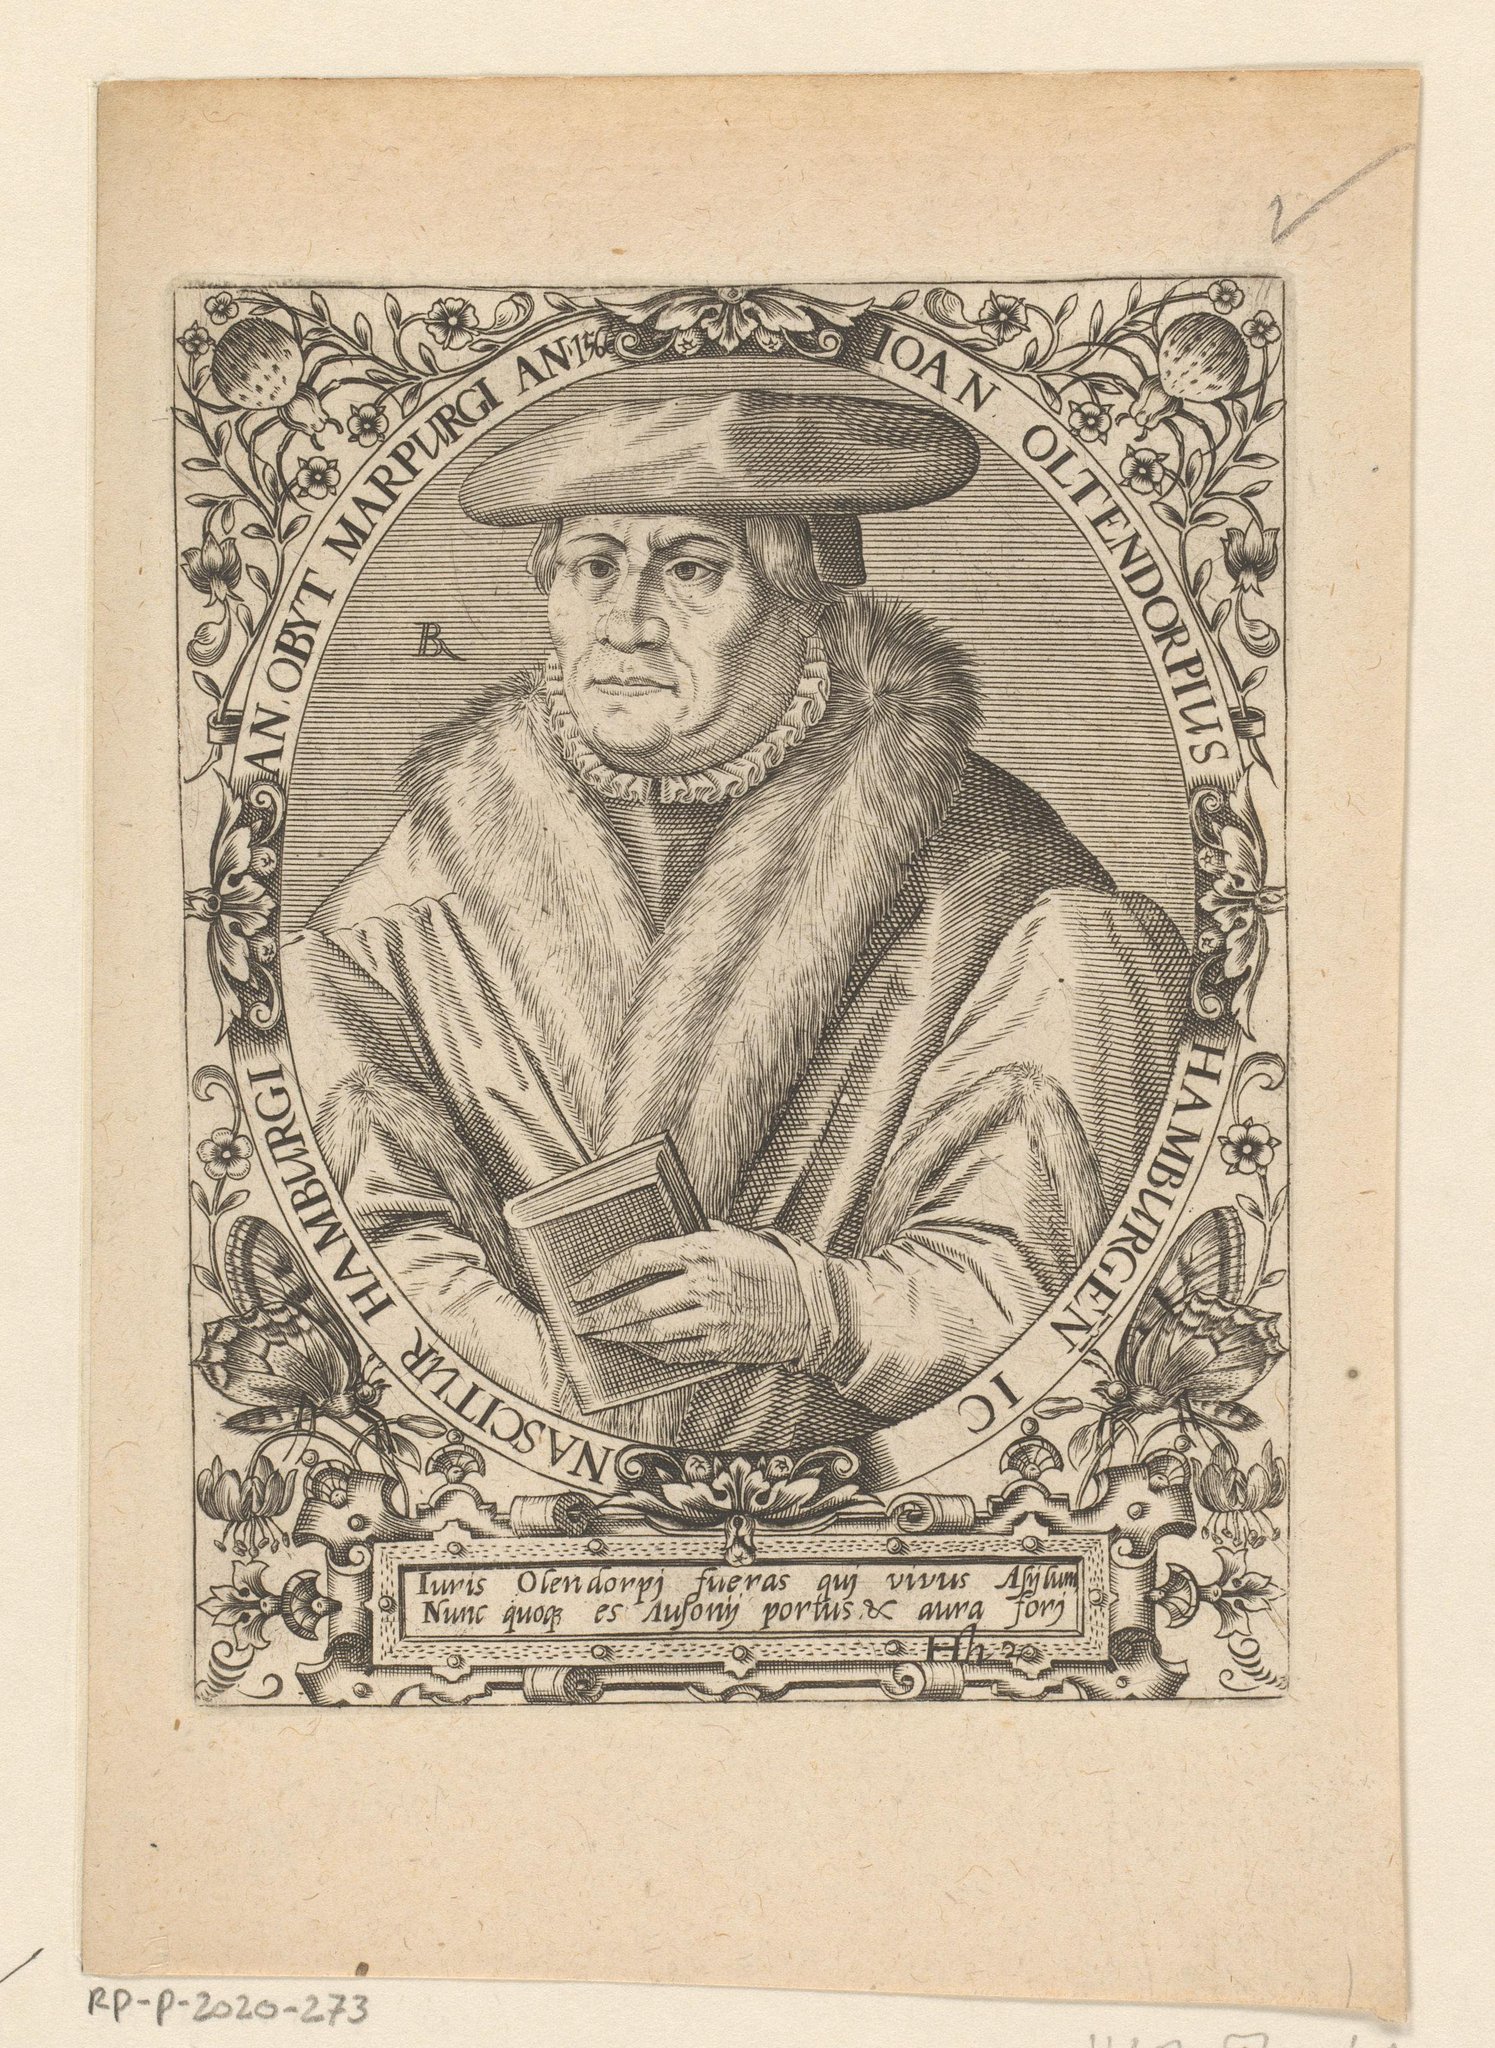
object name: print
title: Ioan Oltendorpius Hamburgen ic nascitur Hamburgi an. obyt Marpurgi An. 1566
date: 1650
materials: paper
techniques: engraving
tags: reformation (roman catholic church vs. protestantism), historical persons, politician, e.g. party leader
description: Prent gebruikt in: Boissard, Jean Jacques. Bibliotheca chalcographica. 8 dln. Frankfurt am Main: Johannes Ammon, 1650-1652. Ook gebruikt in latere edities. Eerdere staat van prent verschenen in: Boissard, Jean Jacques. Icones quinquaginta virorum illustrium doctrina & eruditione praestantium ad vivum effictae. 4 dln. Frankfurt am Main: s.n., 1597-1599. Mogelijk ook gebruikt in latere edities.